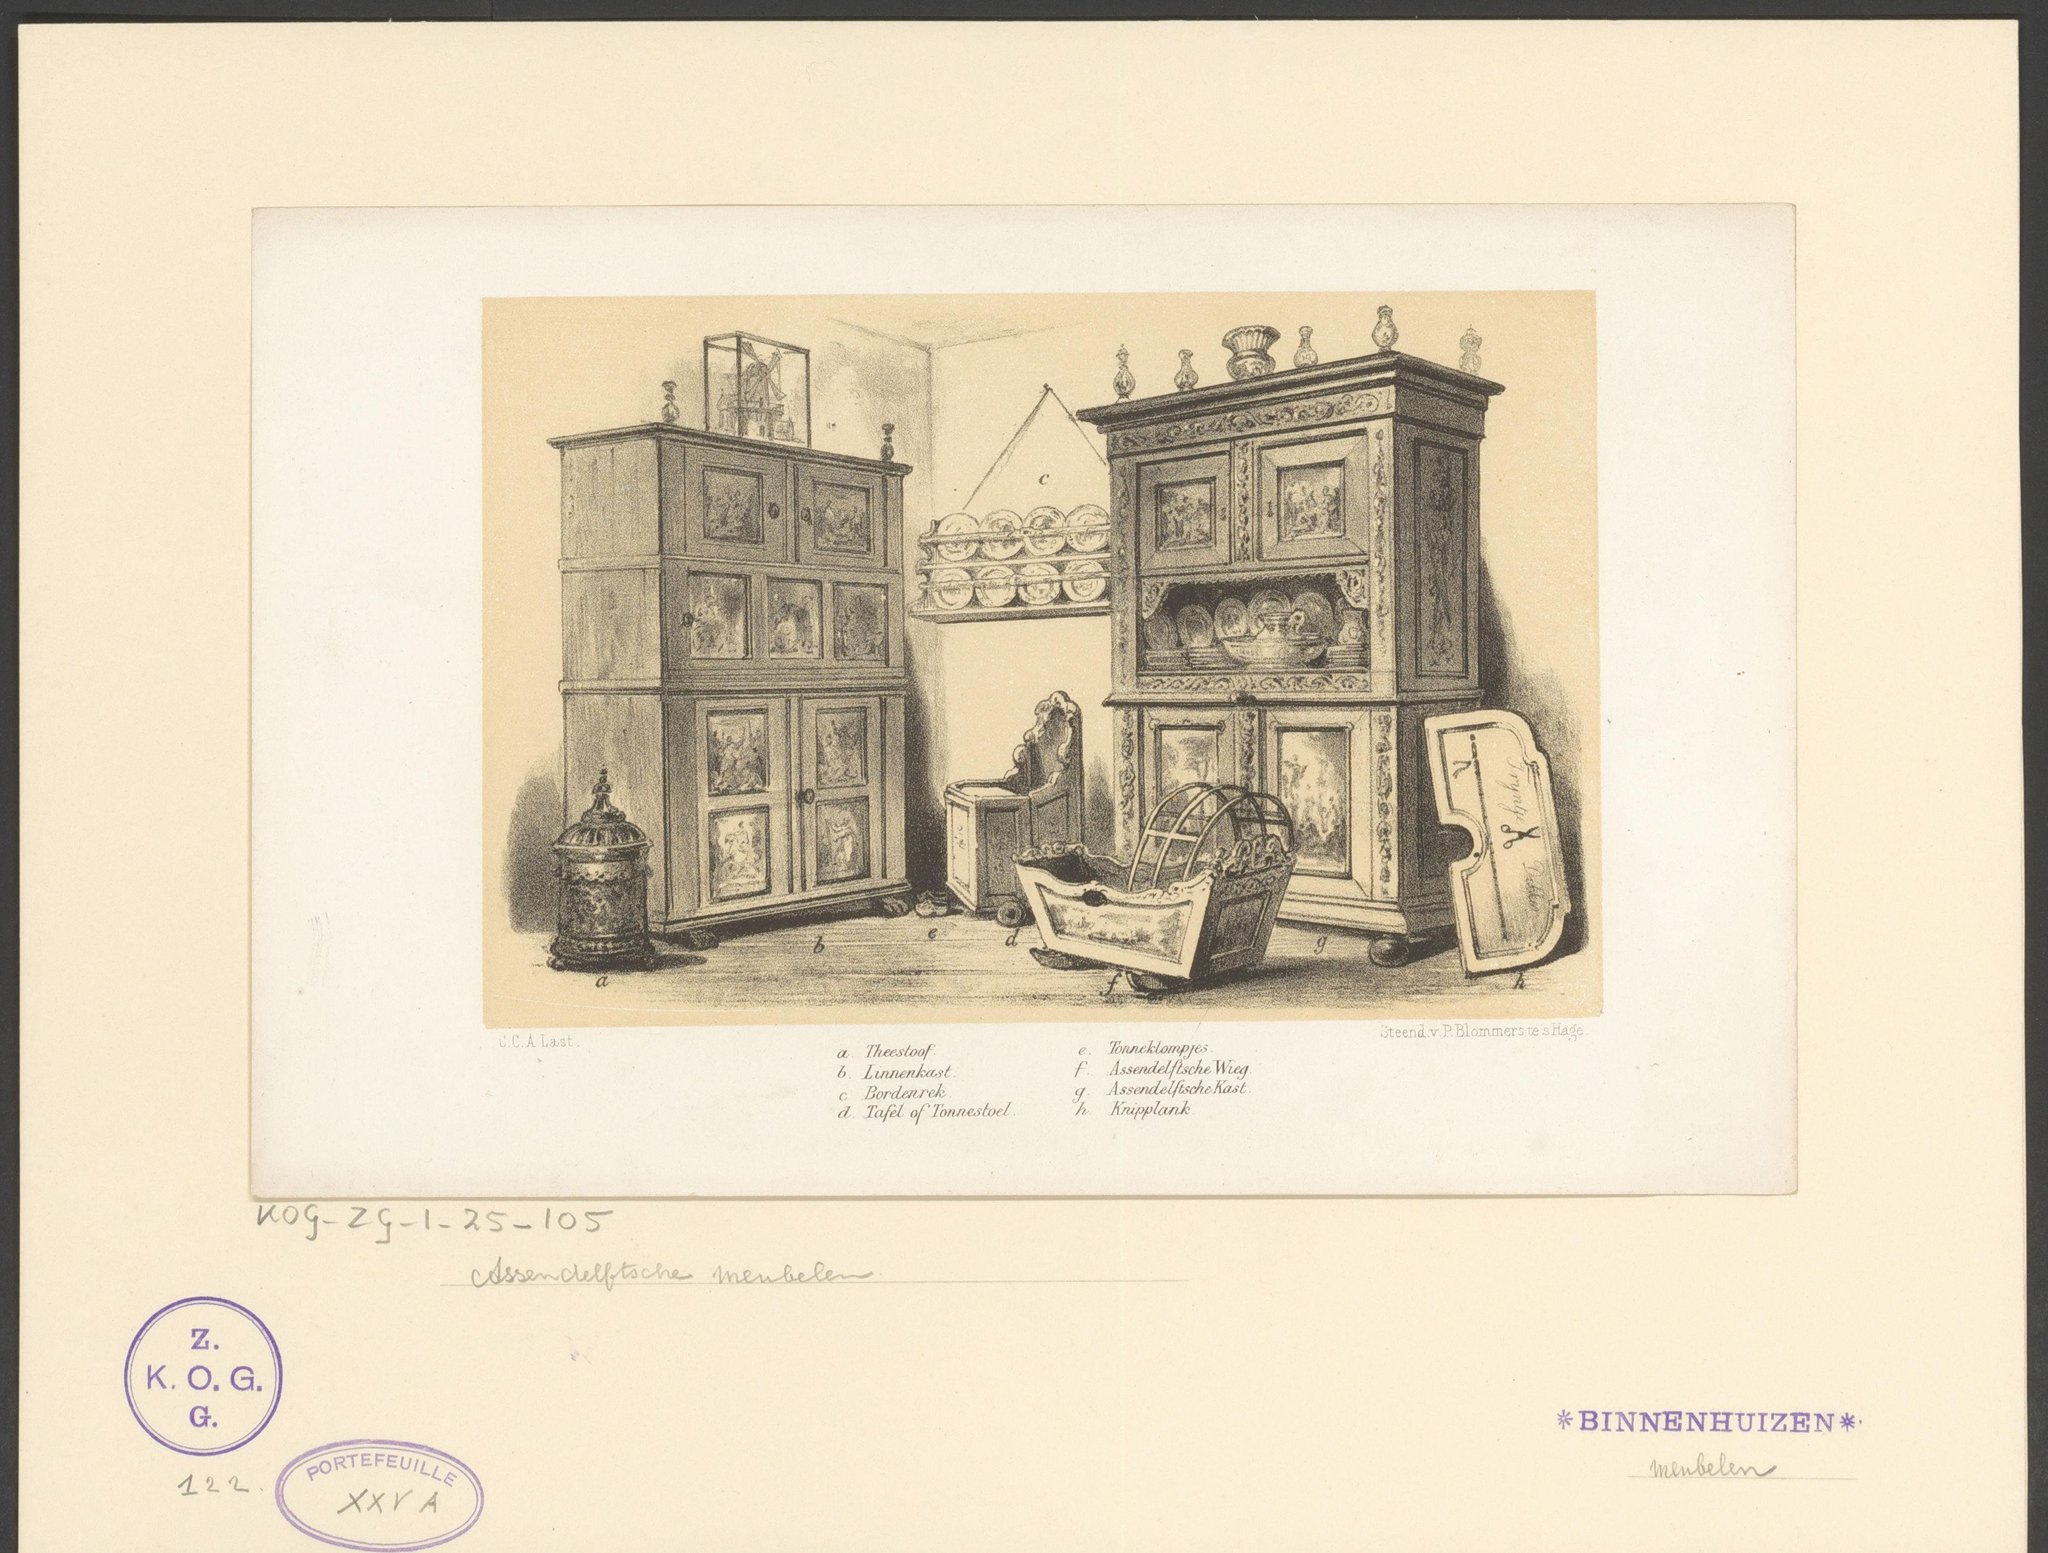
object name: print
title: Interieur met theestoof, linnenkast, bordenrek, Assendelfsche wieg en Assendelfsche kast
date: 1890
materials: paper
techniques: tone lithography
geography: the hague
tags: cradle, crib, dish, plate, saucer, linen-closet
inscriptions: stamp, stamp, collector's mark: Lugt 1641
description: Interieur met theestoof, linnenkast, bordenrek, Assendelfsche wieg en Assendelfsche kast. Onderaan een legenda van a tot en met h. Onderwerpsrubrieken binnen de Atlas Zeden en Gewoonten: Zeden en Gewoonten in Engeren Zin, De Woning, Binnenhuizen, Meubelen.